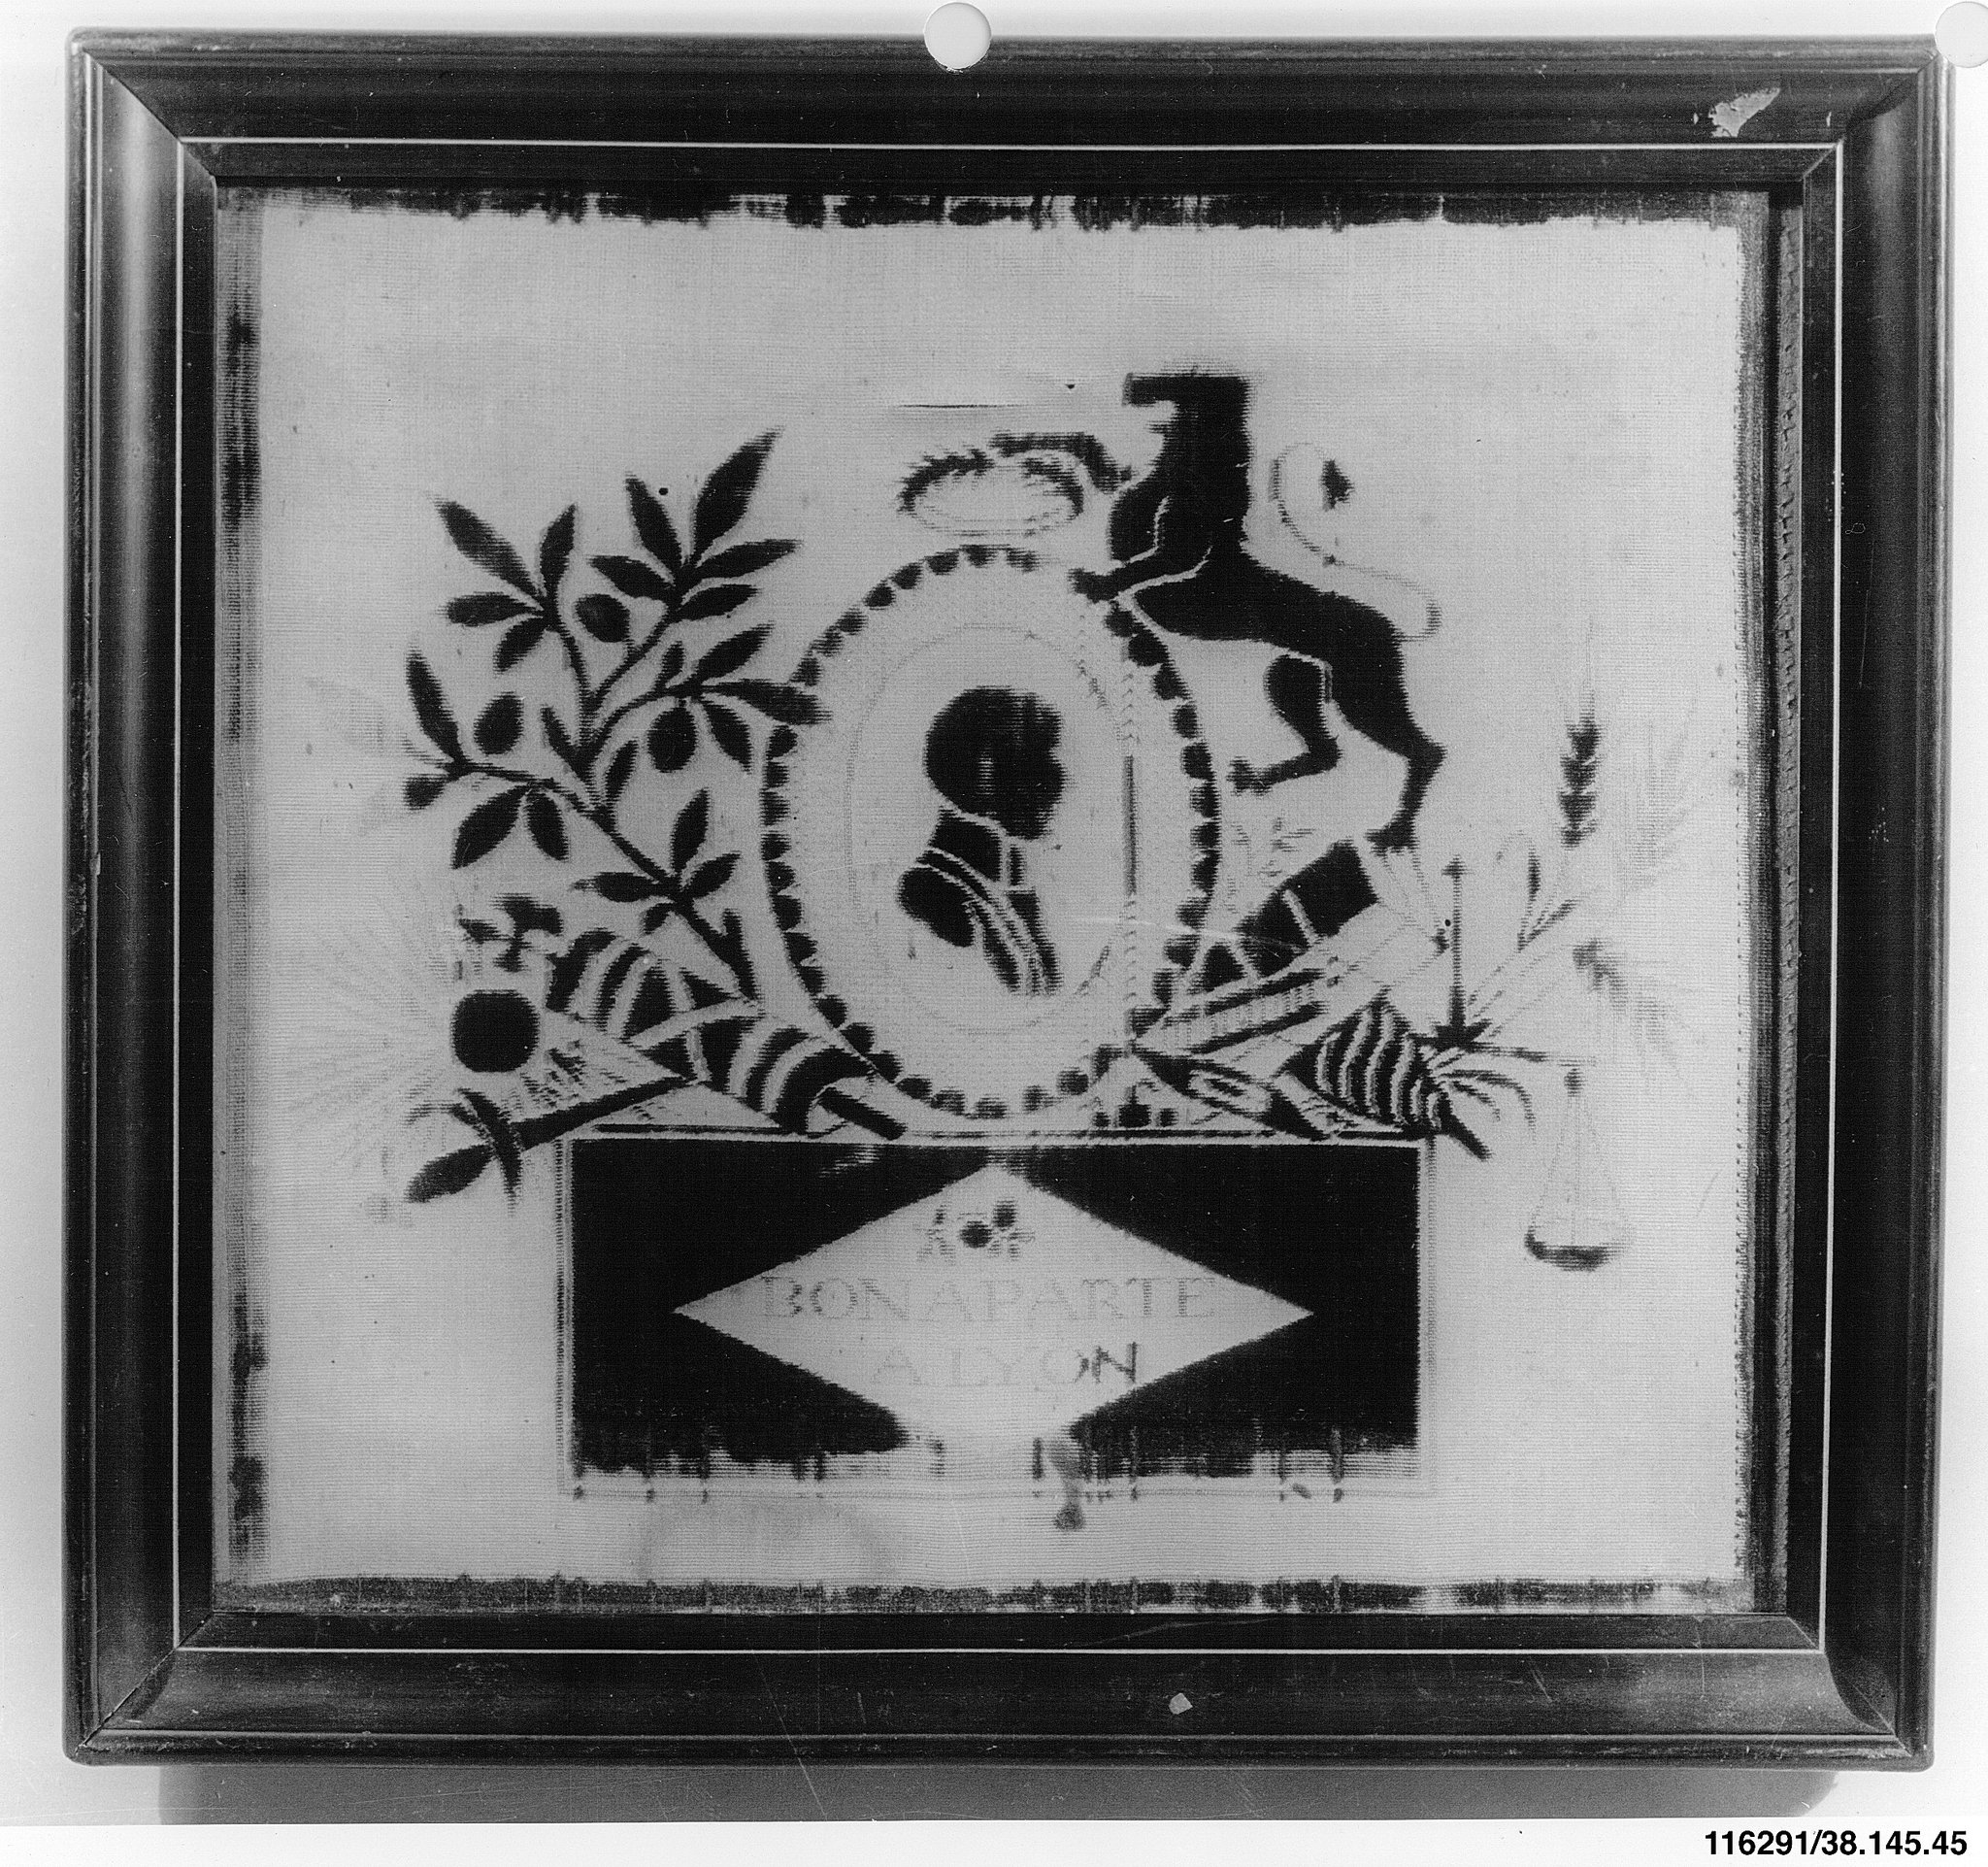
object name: panel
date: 1799-1804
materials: silk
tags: animals,men,profiles,insignia